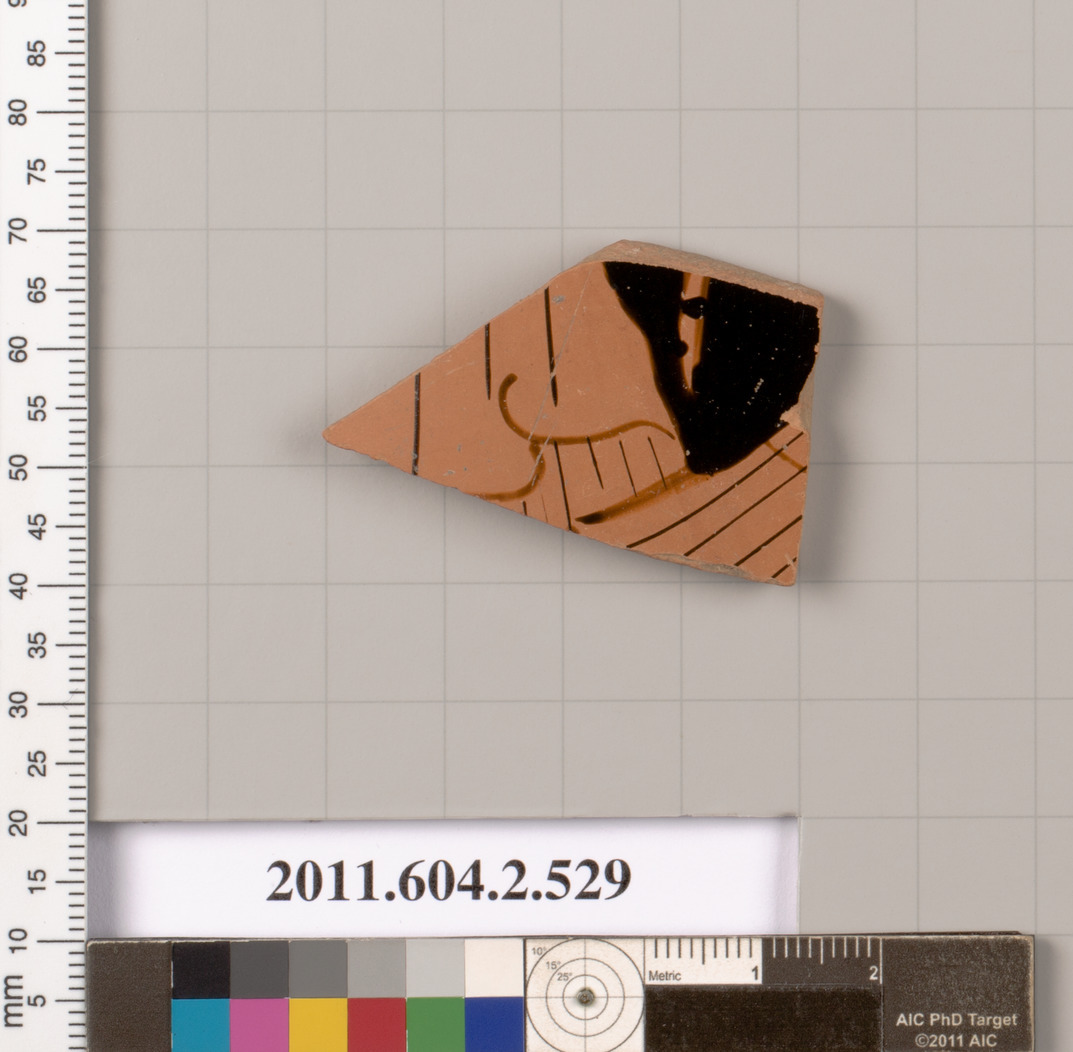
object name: column krater fragment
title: Terracotta fragment of a column-krater (bowl for mixing wine and water)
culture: greek, attic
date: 440-420 BCE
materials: terracotta